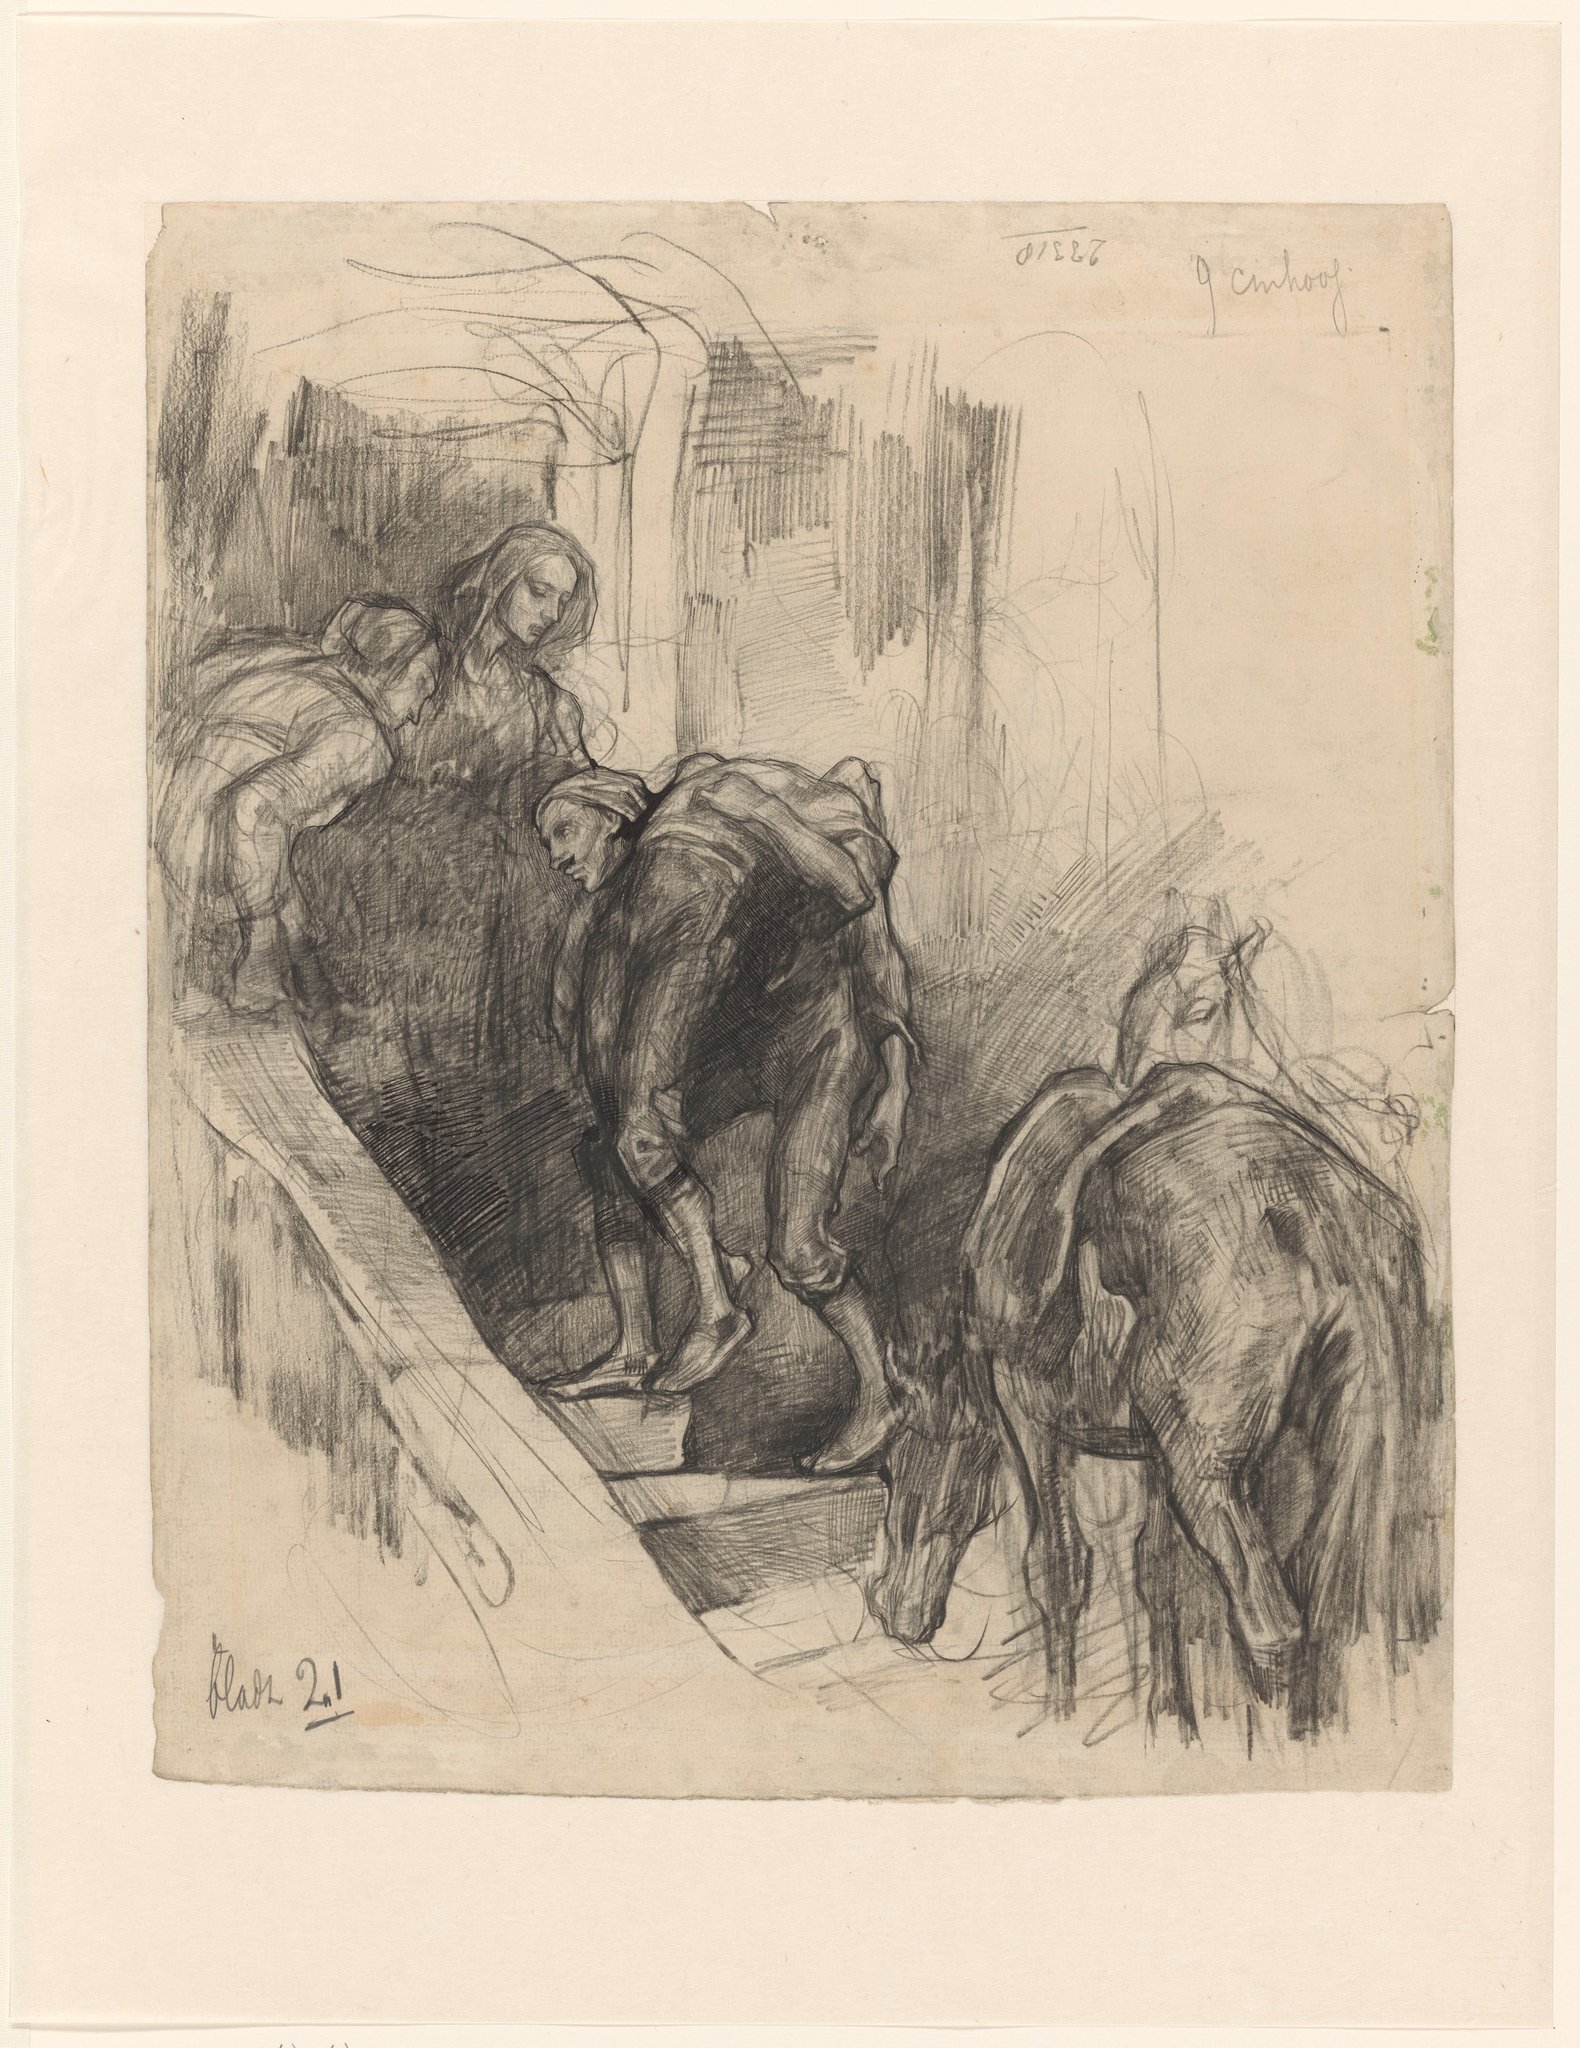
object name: drawing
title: Episode uit de Barmhartige Samaritaan: de gewonde man wordt de herberg binnen gedragen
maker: johannes hendricus jurres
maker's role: draughtsman, print maker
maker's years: 1875-1946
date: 1885-1922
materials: chalk, paper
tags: the samaritan and the wounded traveller arrive at the inn; the traveller is cared for